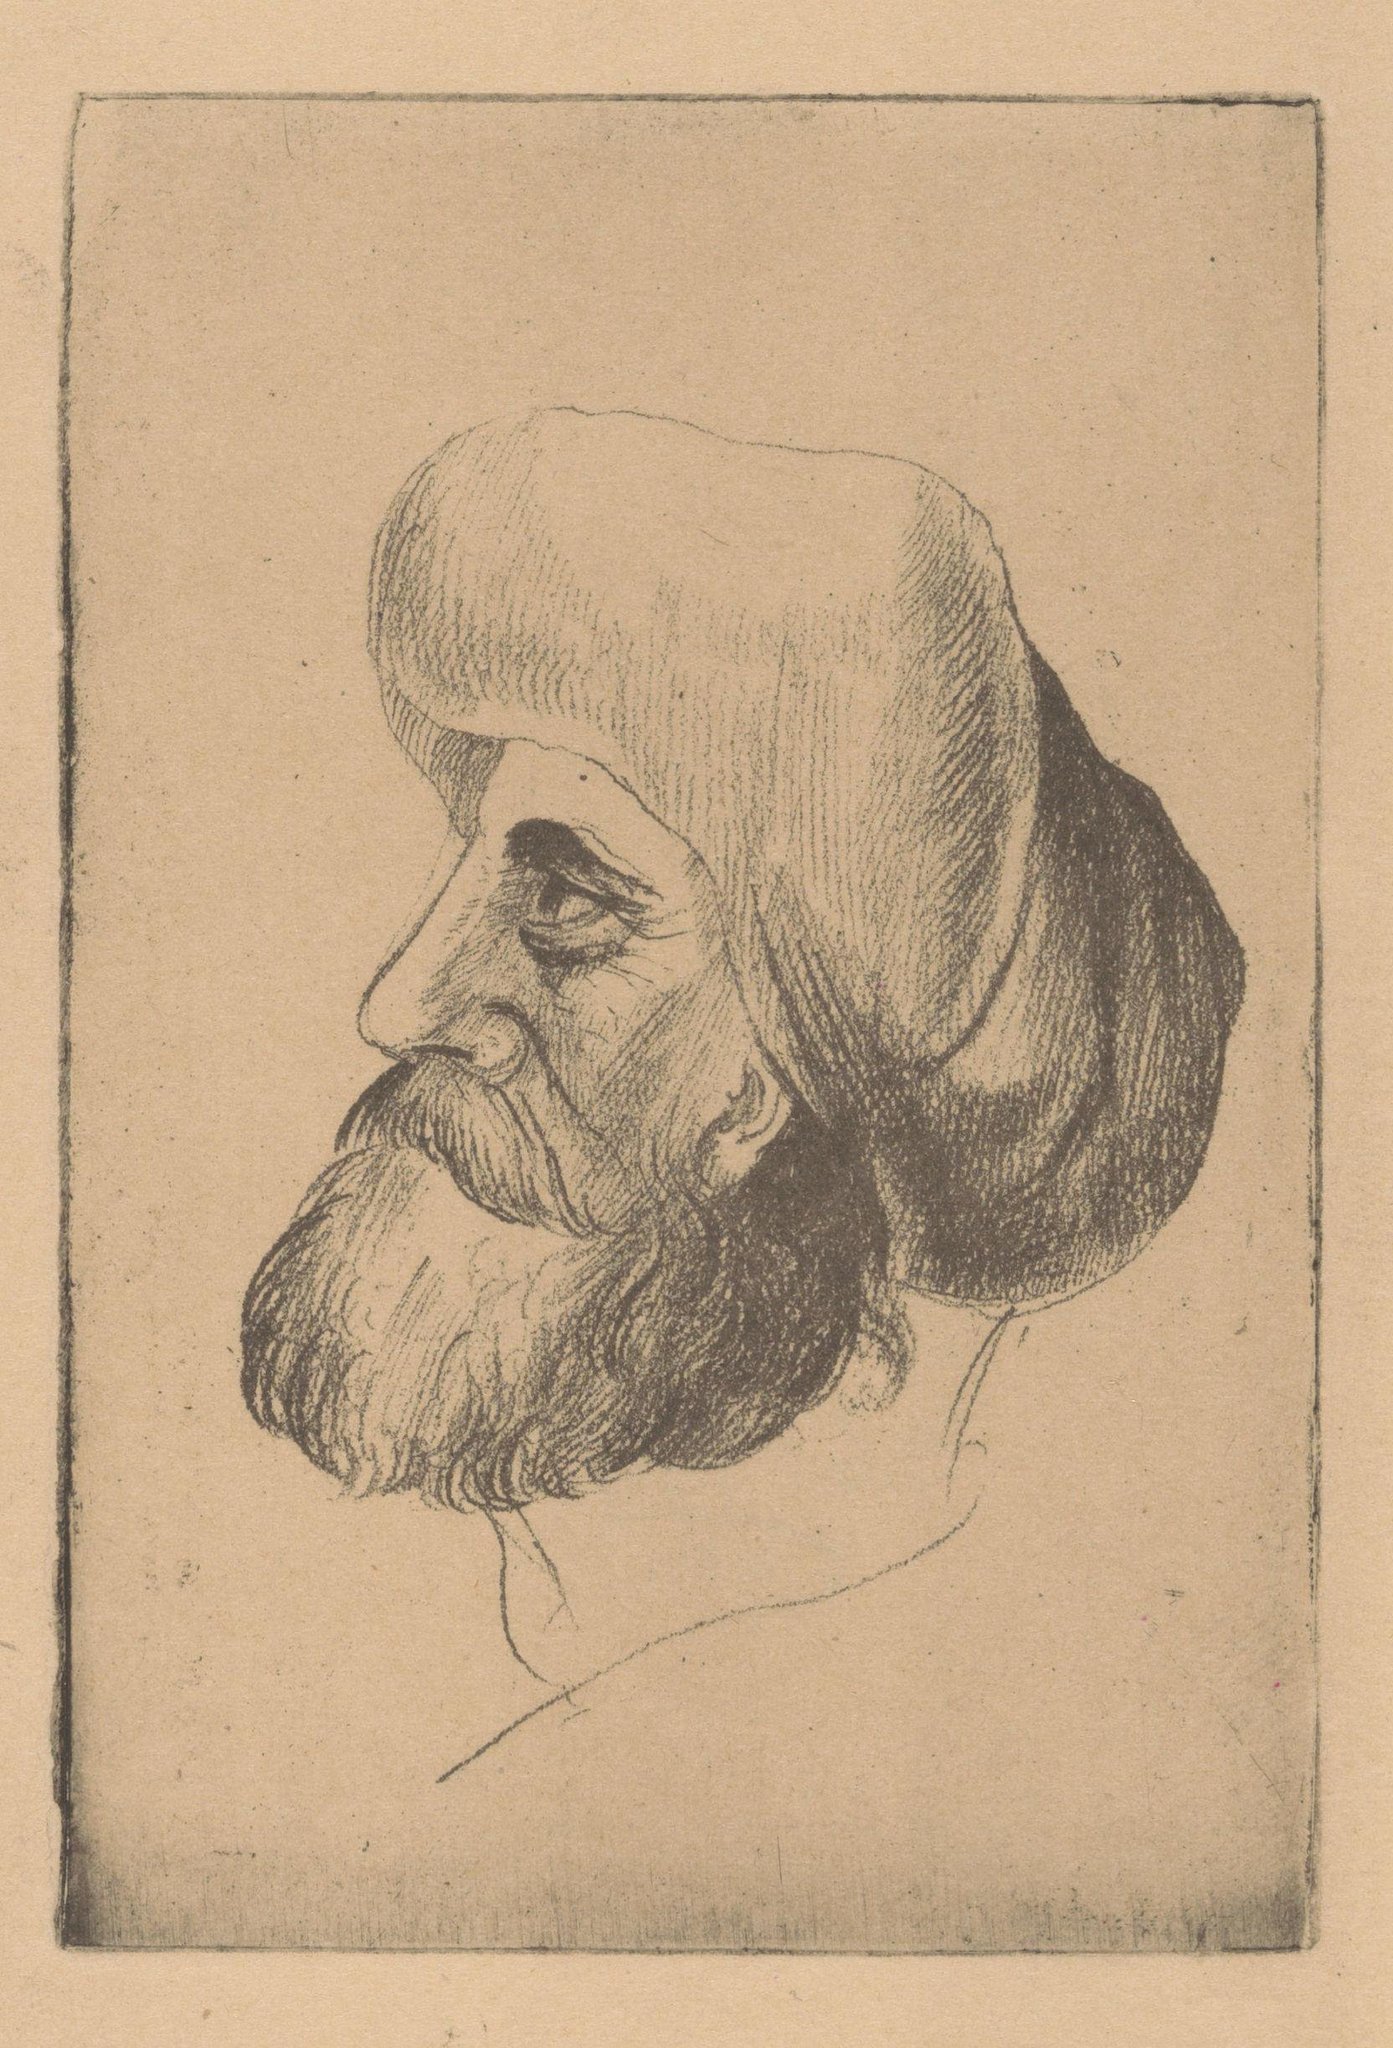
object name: print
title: Man met baard en tulband en profil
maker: marius holleman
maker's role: draughtsman, print maker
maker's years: 1878-1926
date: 1904-1926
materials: paper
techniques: etching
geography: groningen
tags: head-gear: turban, beard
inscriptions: collector's mark: Lugt 2228